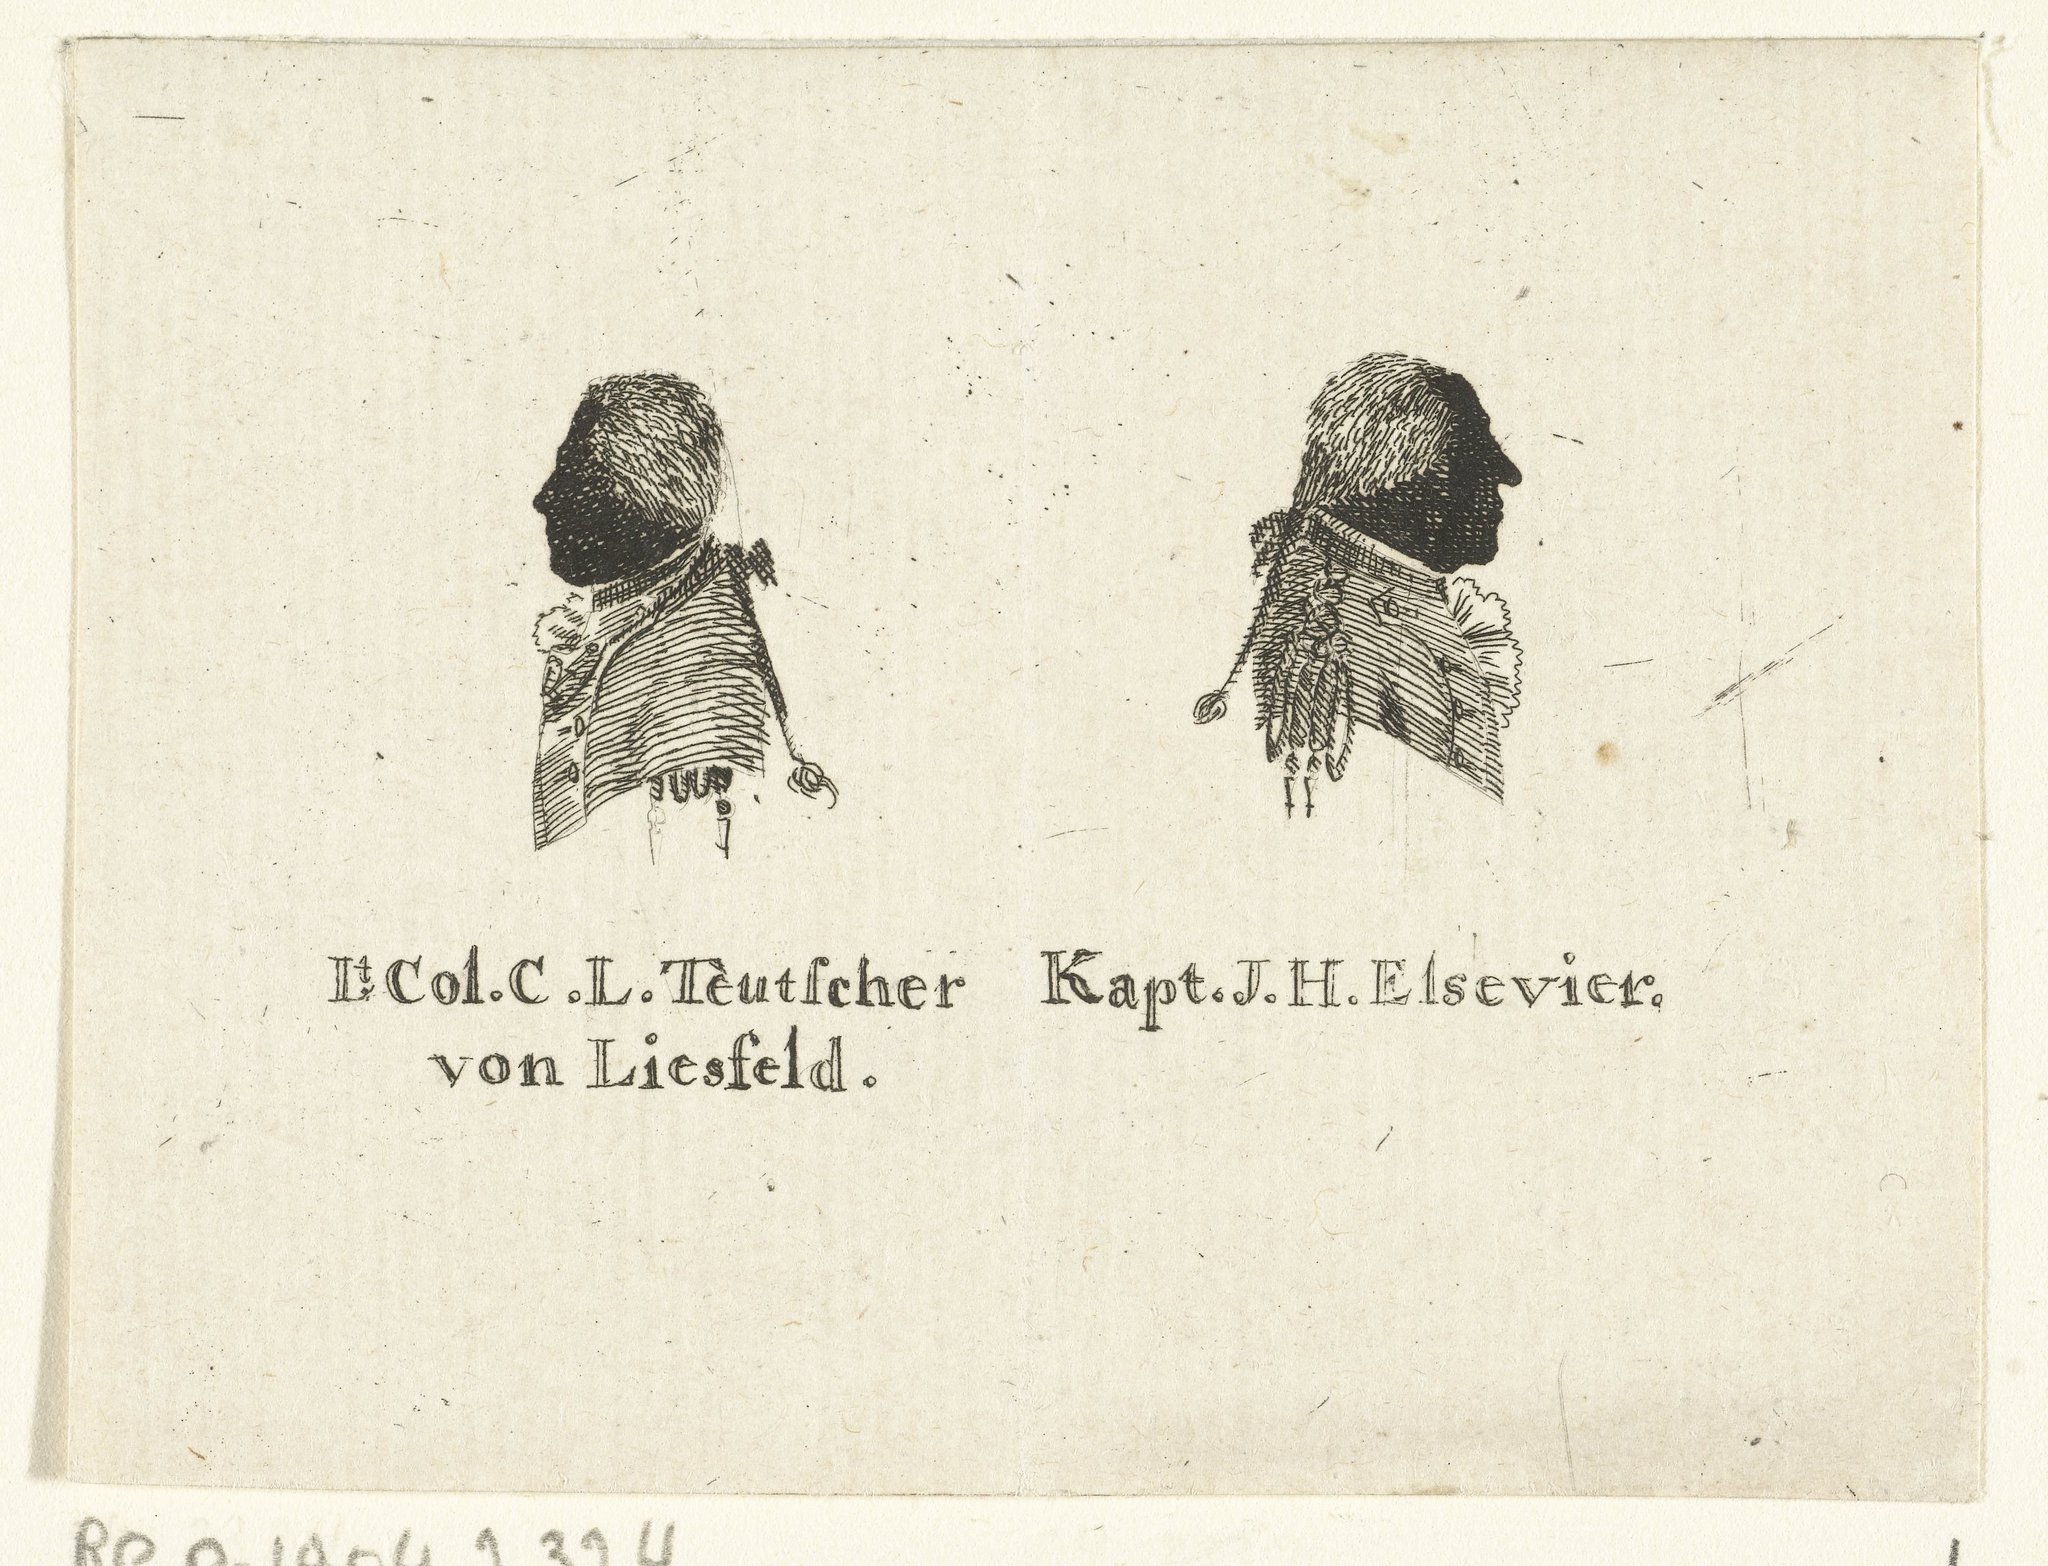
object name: print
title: Zakboekje van de helden van de Willemstad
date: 1794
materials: paper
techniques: etching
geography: amsterdam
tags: c.l. teutscher von liesfeld, j.h. elsevier, beleg van willemstad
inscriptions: collector's mark: Lugt 2228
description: Twee silhouetportretten uit een boekje over de soldaten die Willemstad hebben verdedigd in 1793. De linker is van kolonel C.L. Teutscher von Liesfeld met buste naar links. De rechter is van kapitein J.H. Elsevier met buste naar rechts. De prent heeft een onderschrift met de namen van de geportretteerde militairen.